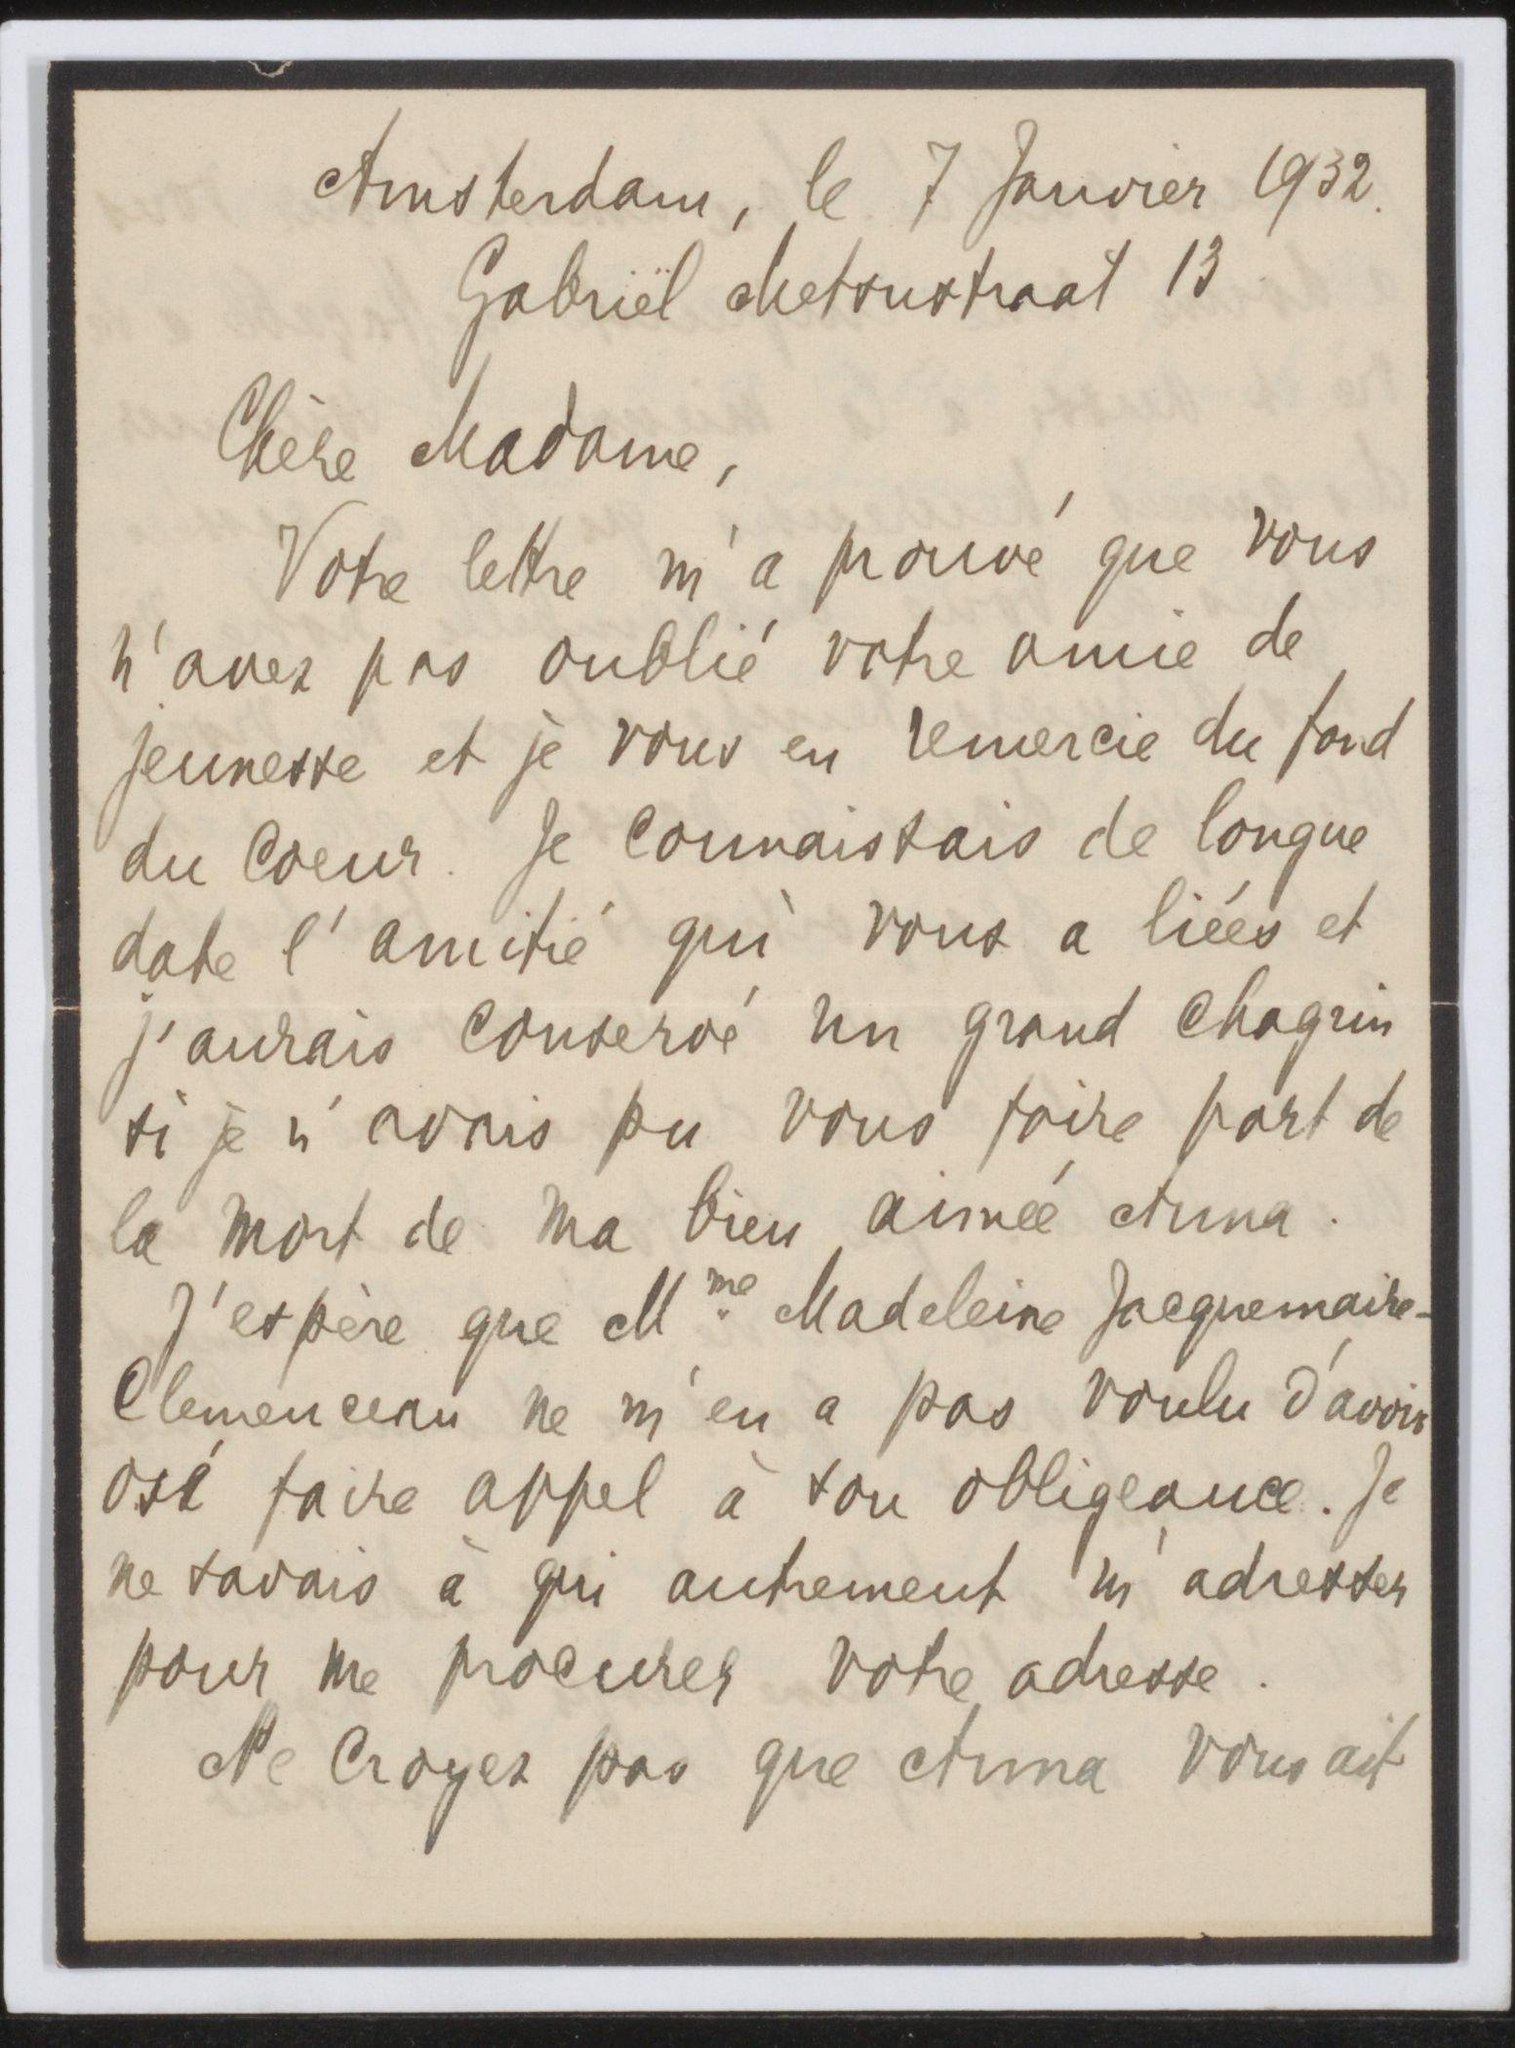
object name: letter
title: Brief aan onbekend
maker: andries bonger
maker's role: kunstverzamelaar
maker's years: 1861-1936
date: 1932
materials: ink, paper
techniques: pen, writing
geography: amsterdam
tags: passions, emotions, affections, diseases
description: De brief is gericht aan een vriendin van Anne Marie Louise van der Linden.